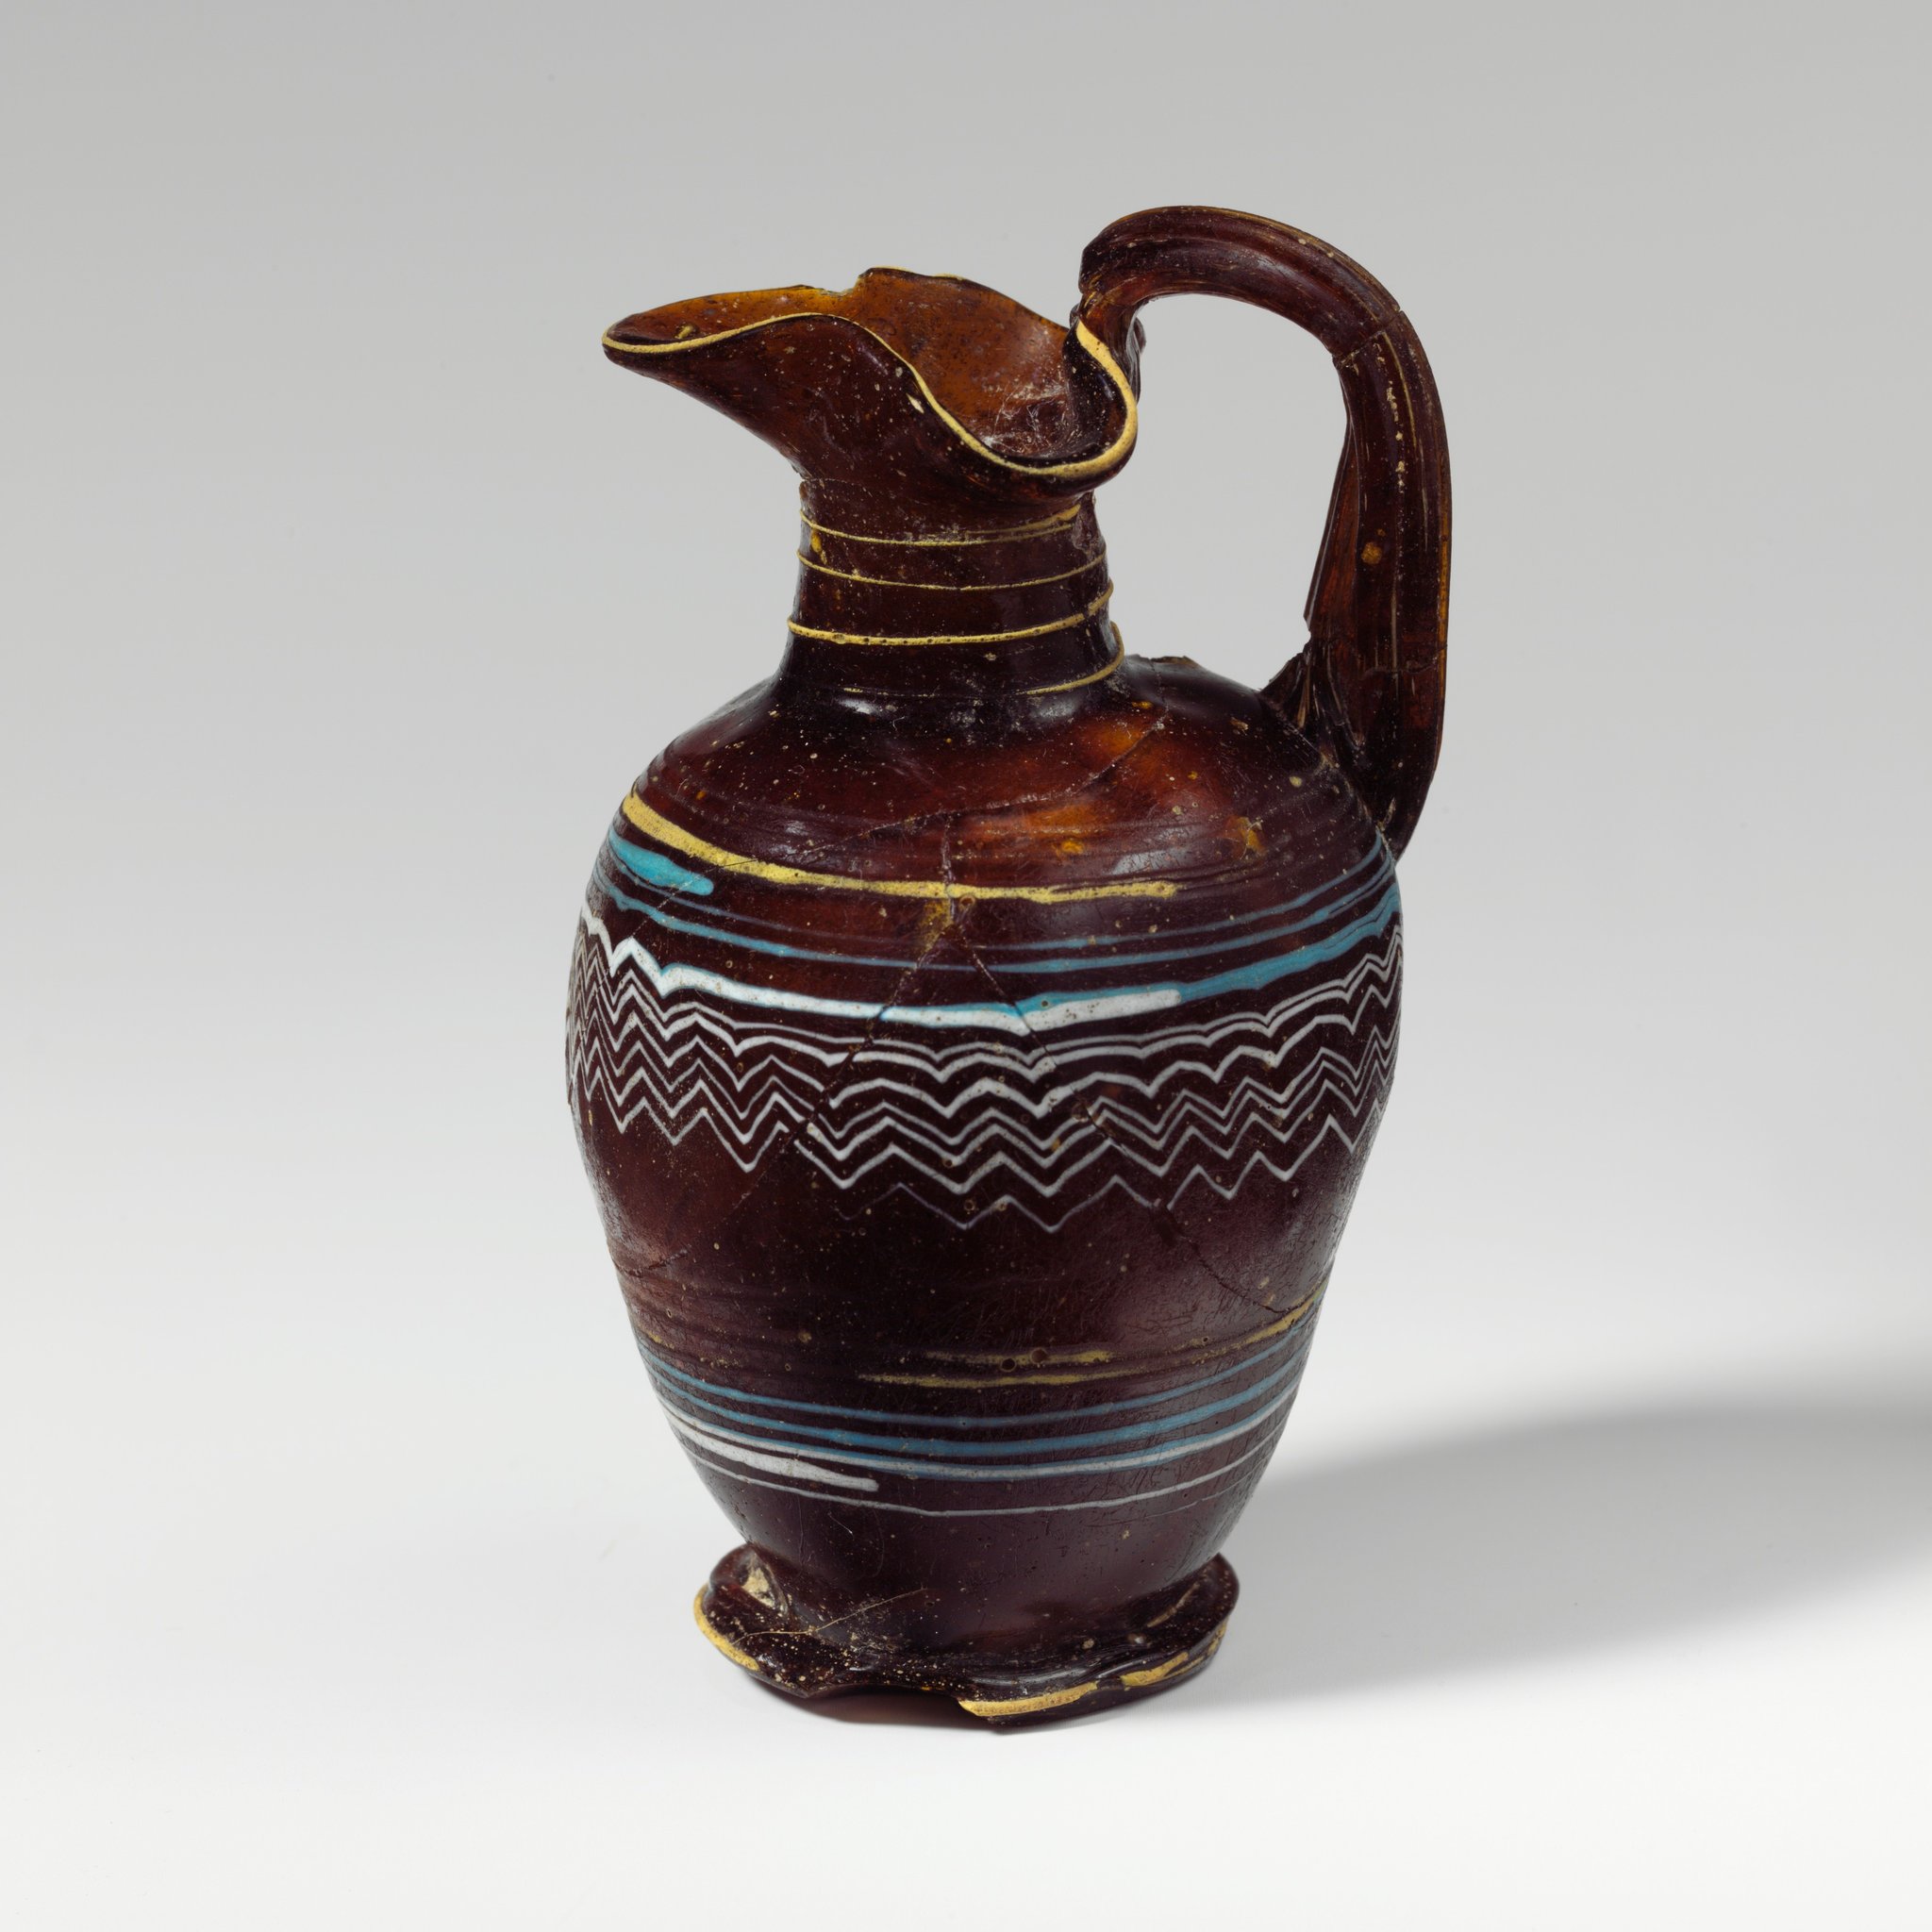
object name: oinochoe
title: Glass oinochoe (perfume jug)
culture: eastern mediterranean or italian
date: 334-268 BCE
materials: glass